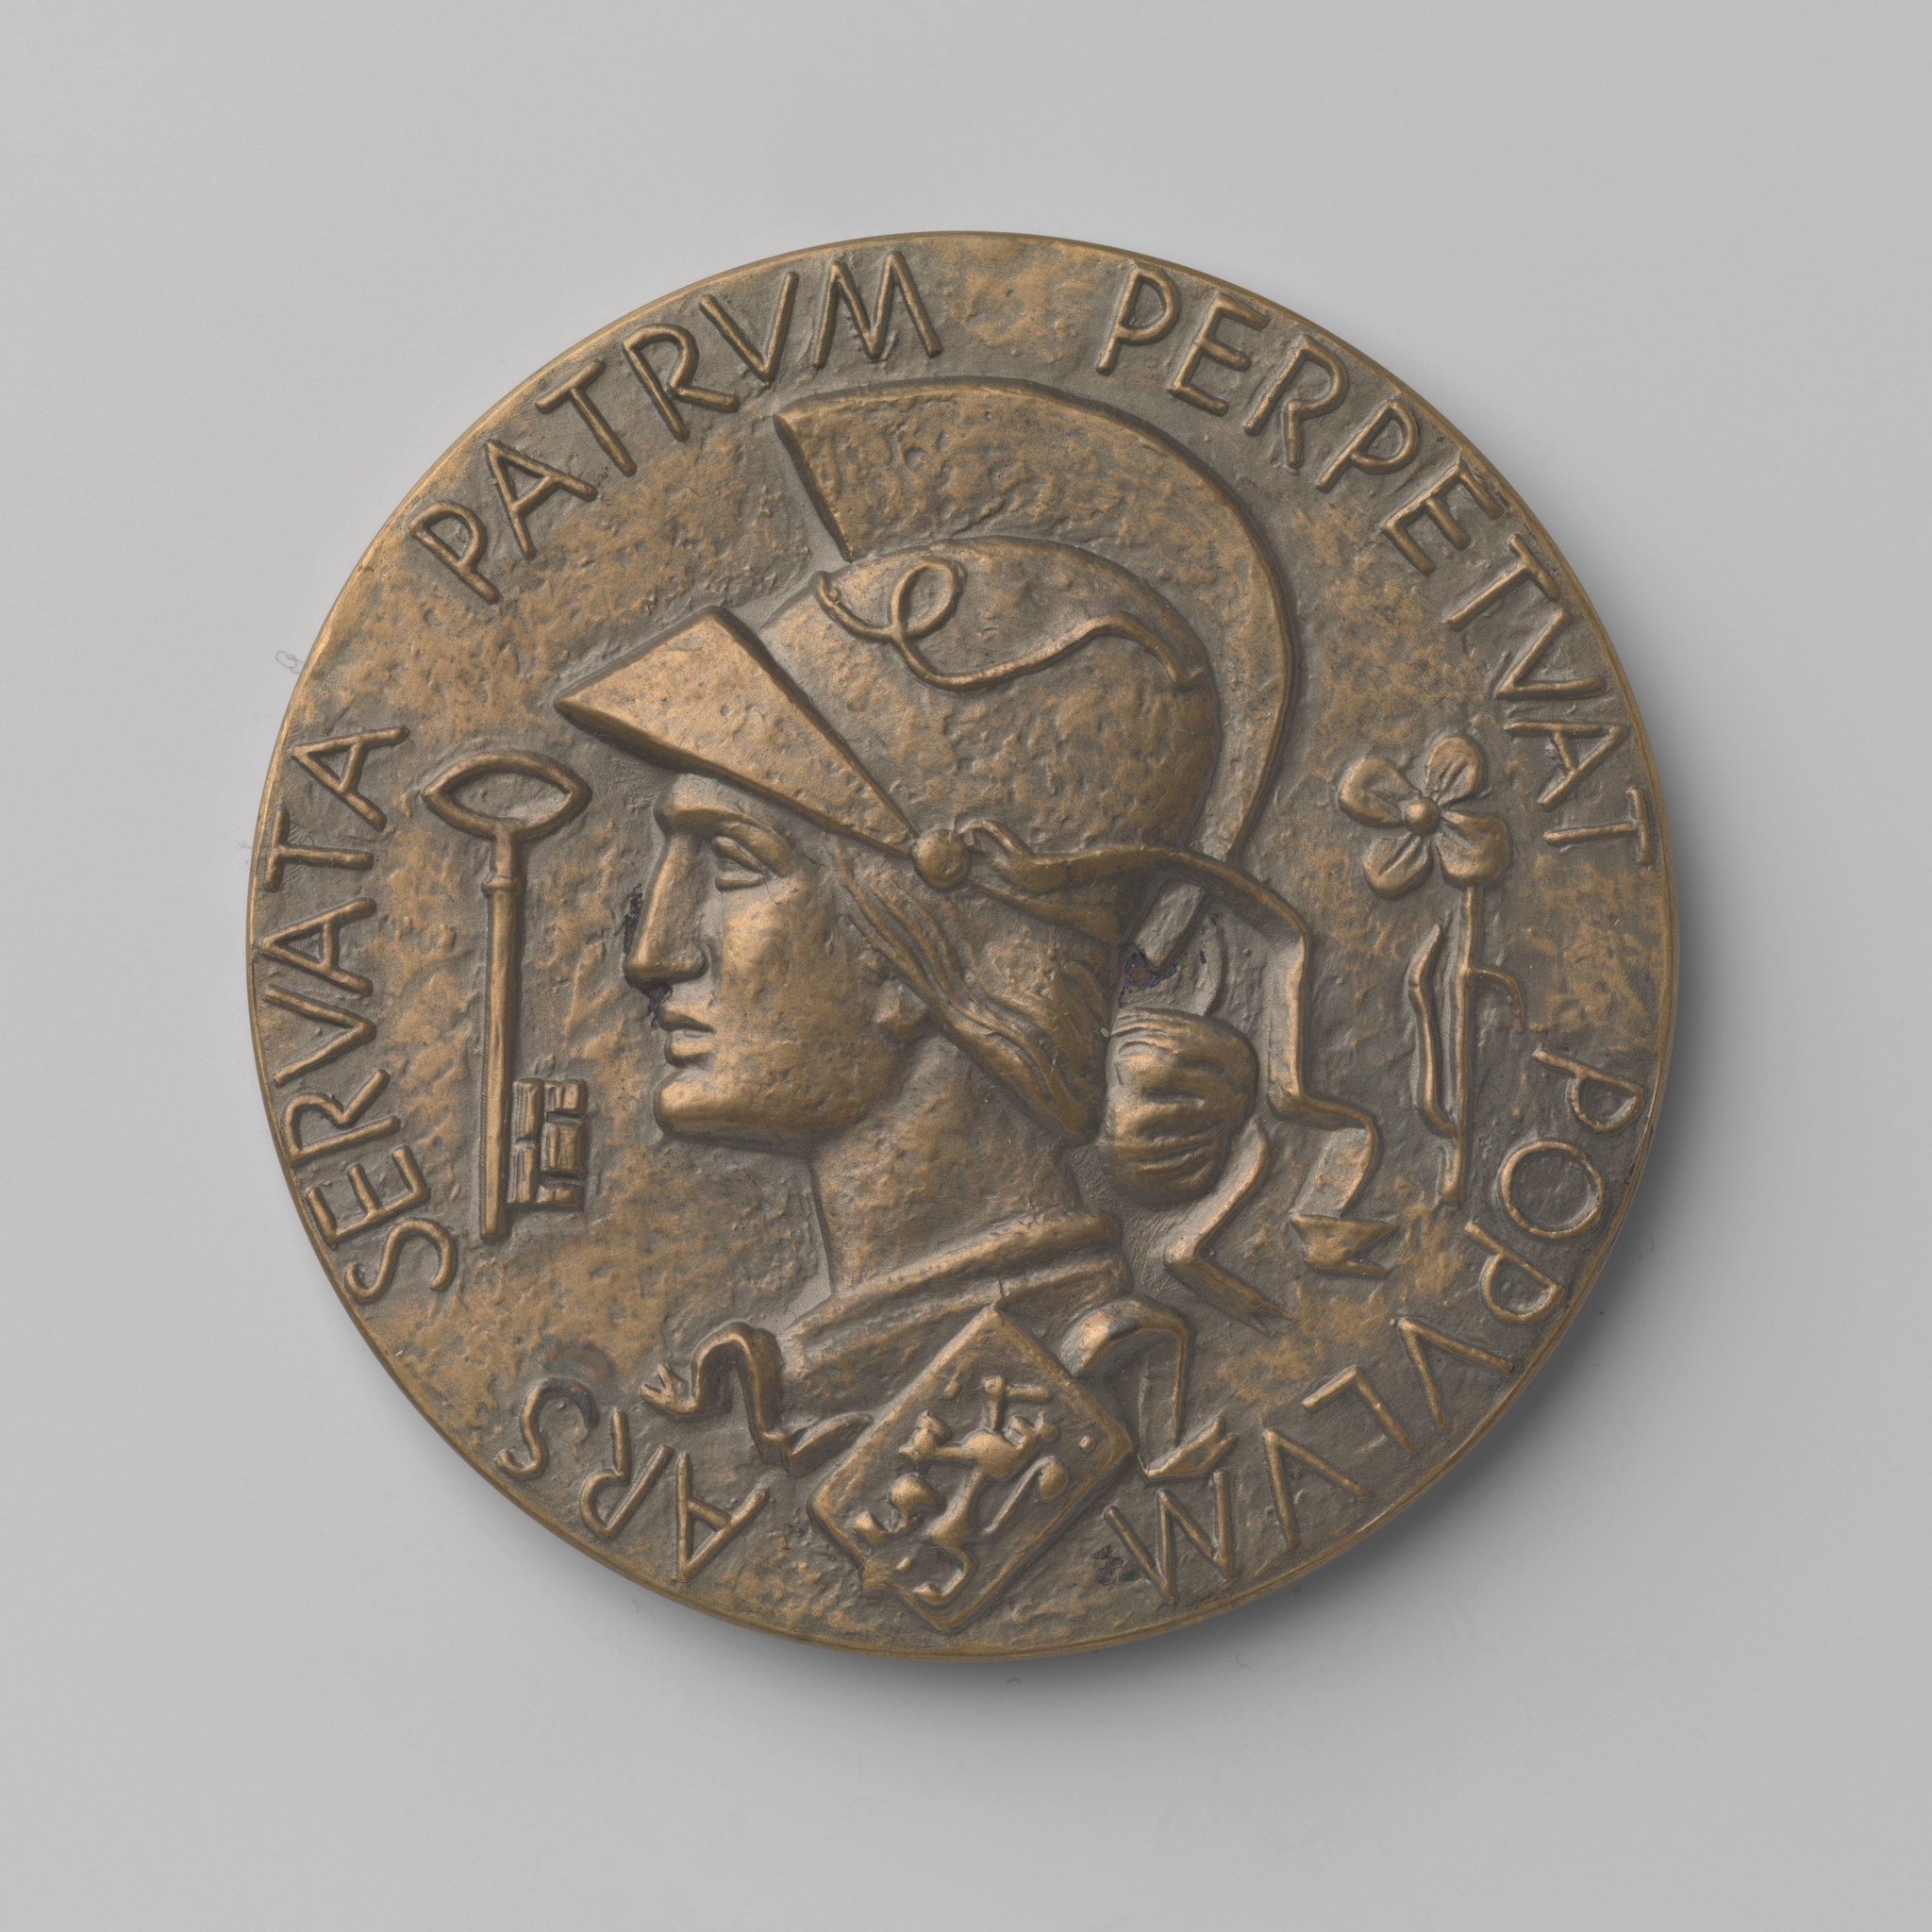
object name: history medal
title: Vijftigjarig bestaan van het Rijksmuseum te Amsterdam 1935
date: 1935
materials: bronze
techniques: striking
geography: utrecht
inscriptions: factory mark: ‘mercuriusstaf’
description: Bronzen penning, op de voorzijde het gehelmde borstbeeld van Minerva naar links tussen een sleutel en een bloem, met omschrift, op de keerzijde het aanzicht van het museumgebouw boven het Nederlandse wapenschild tussen twee jaartallen, met omschrift.